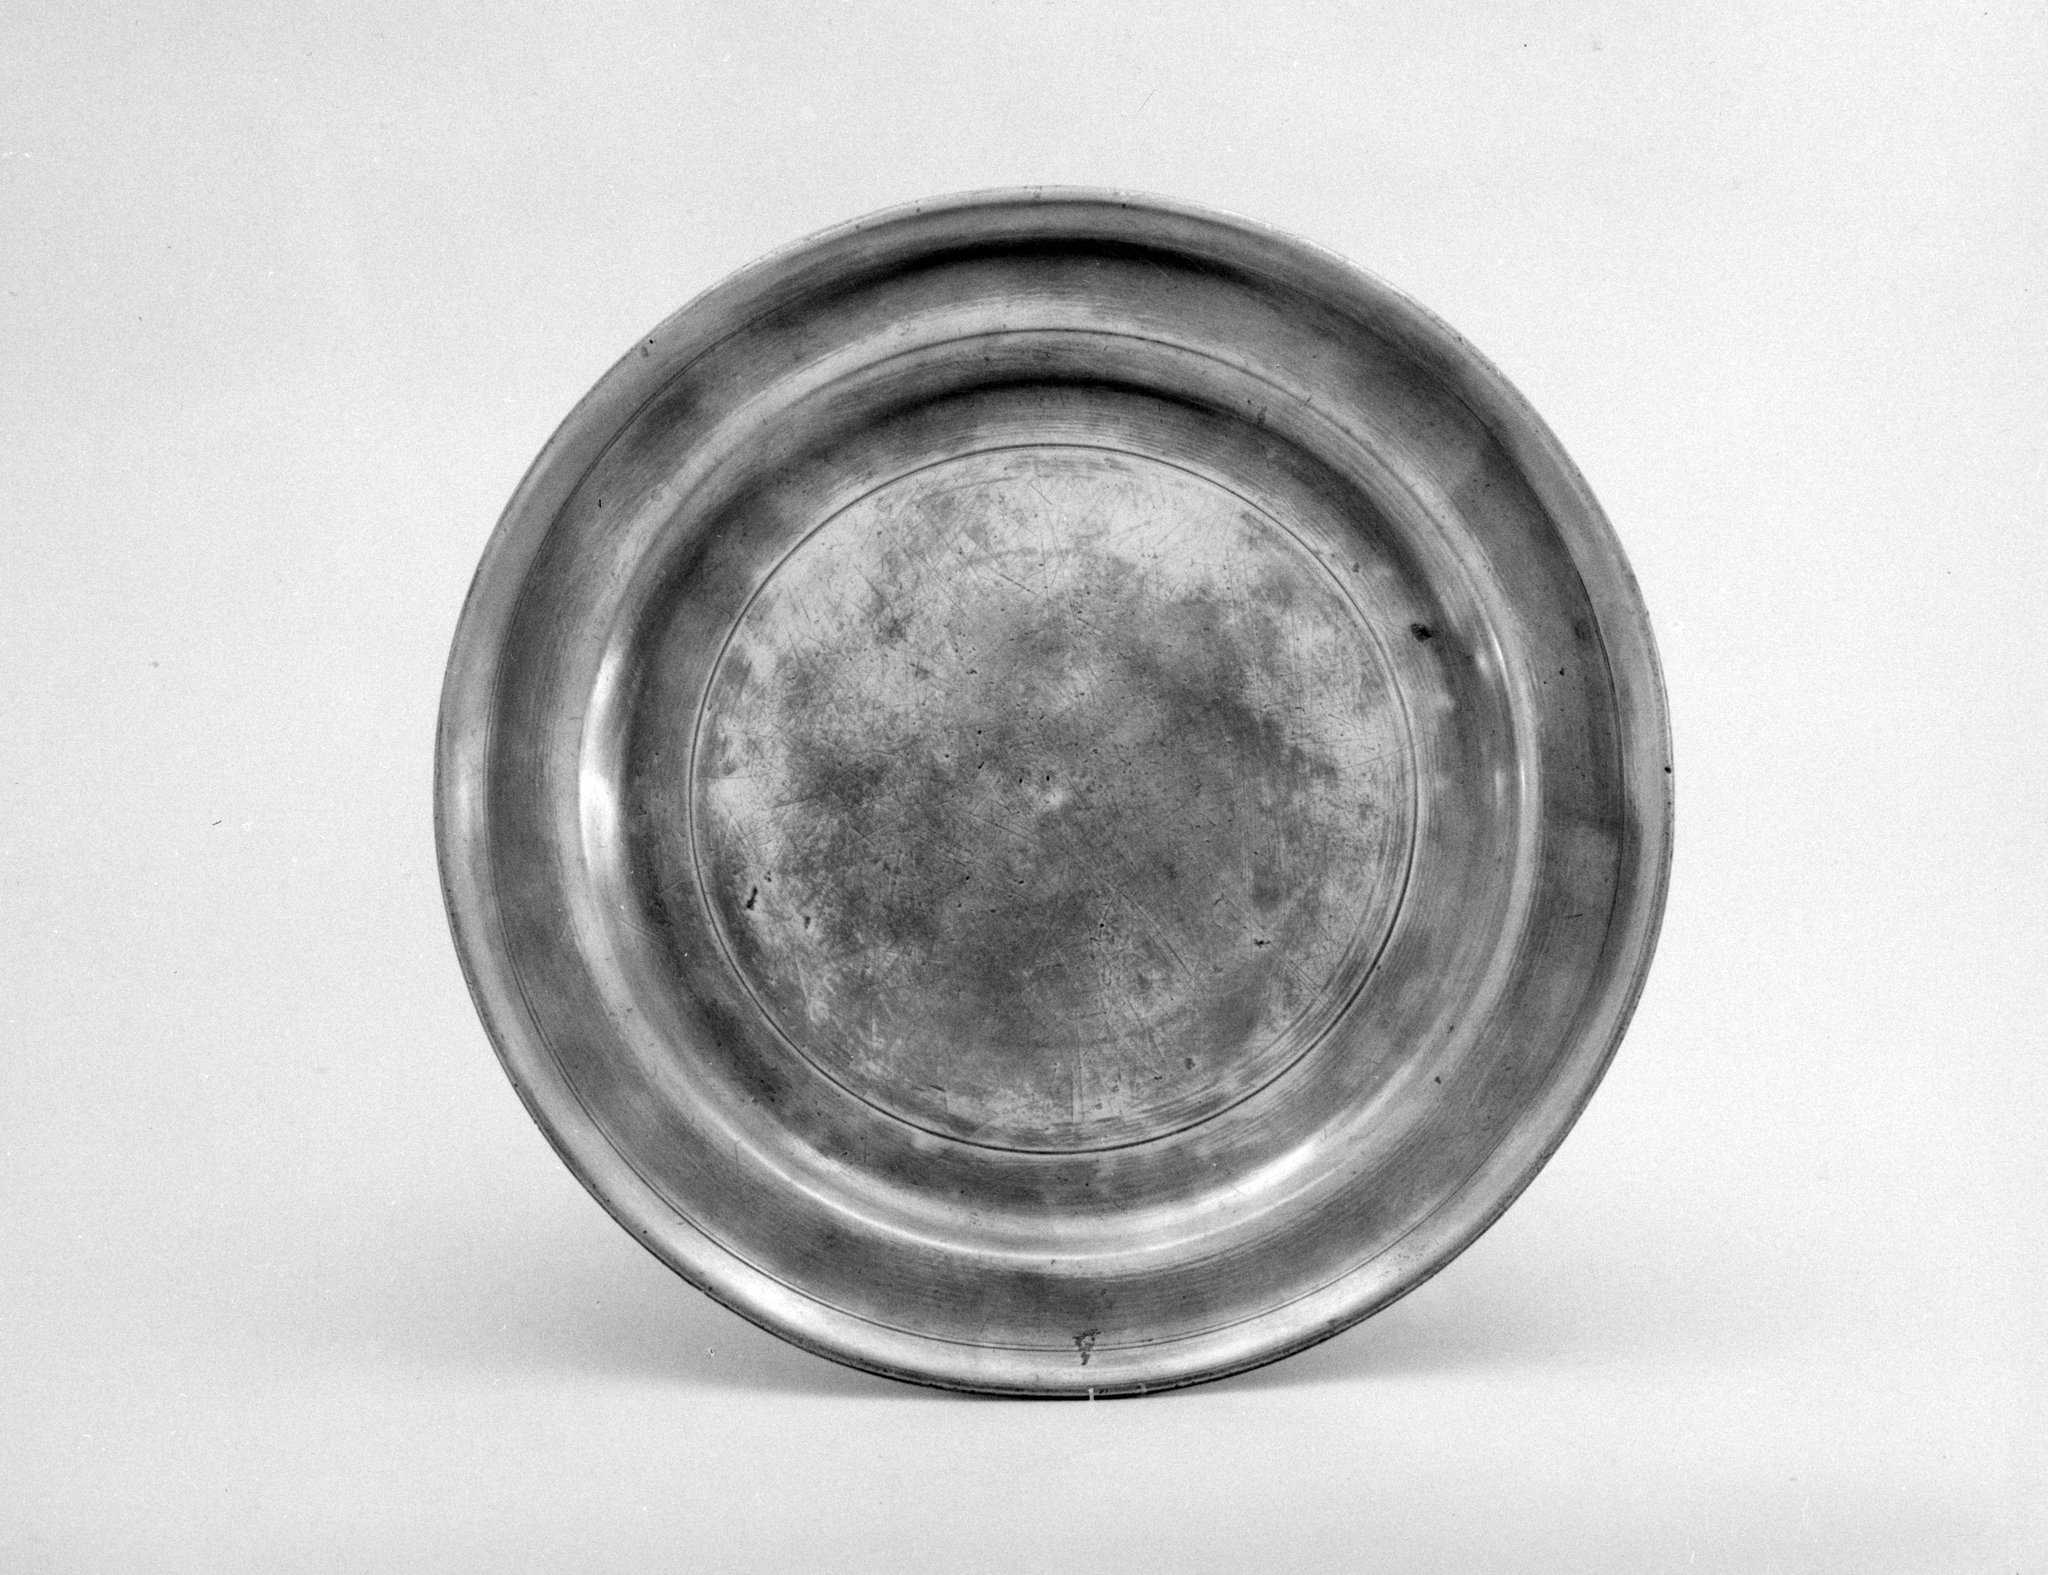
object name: plate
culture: american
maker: robert bonynge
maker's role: maker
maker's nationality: american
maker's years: 1728-1763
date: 1731-1763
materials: pewter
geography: united states